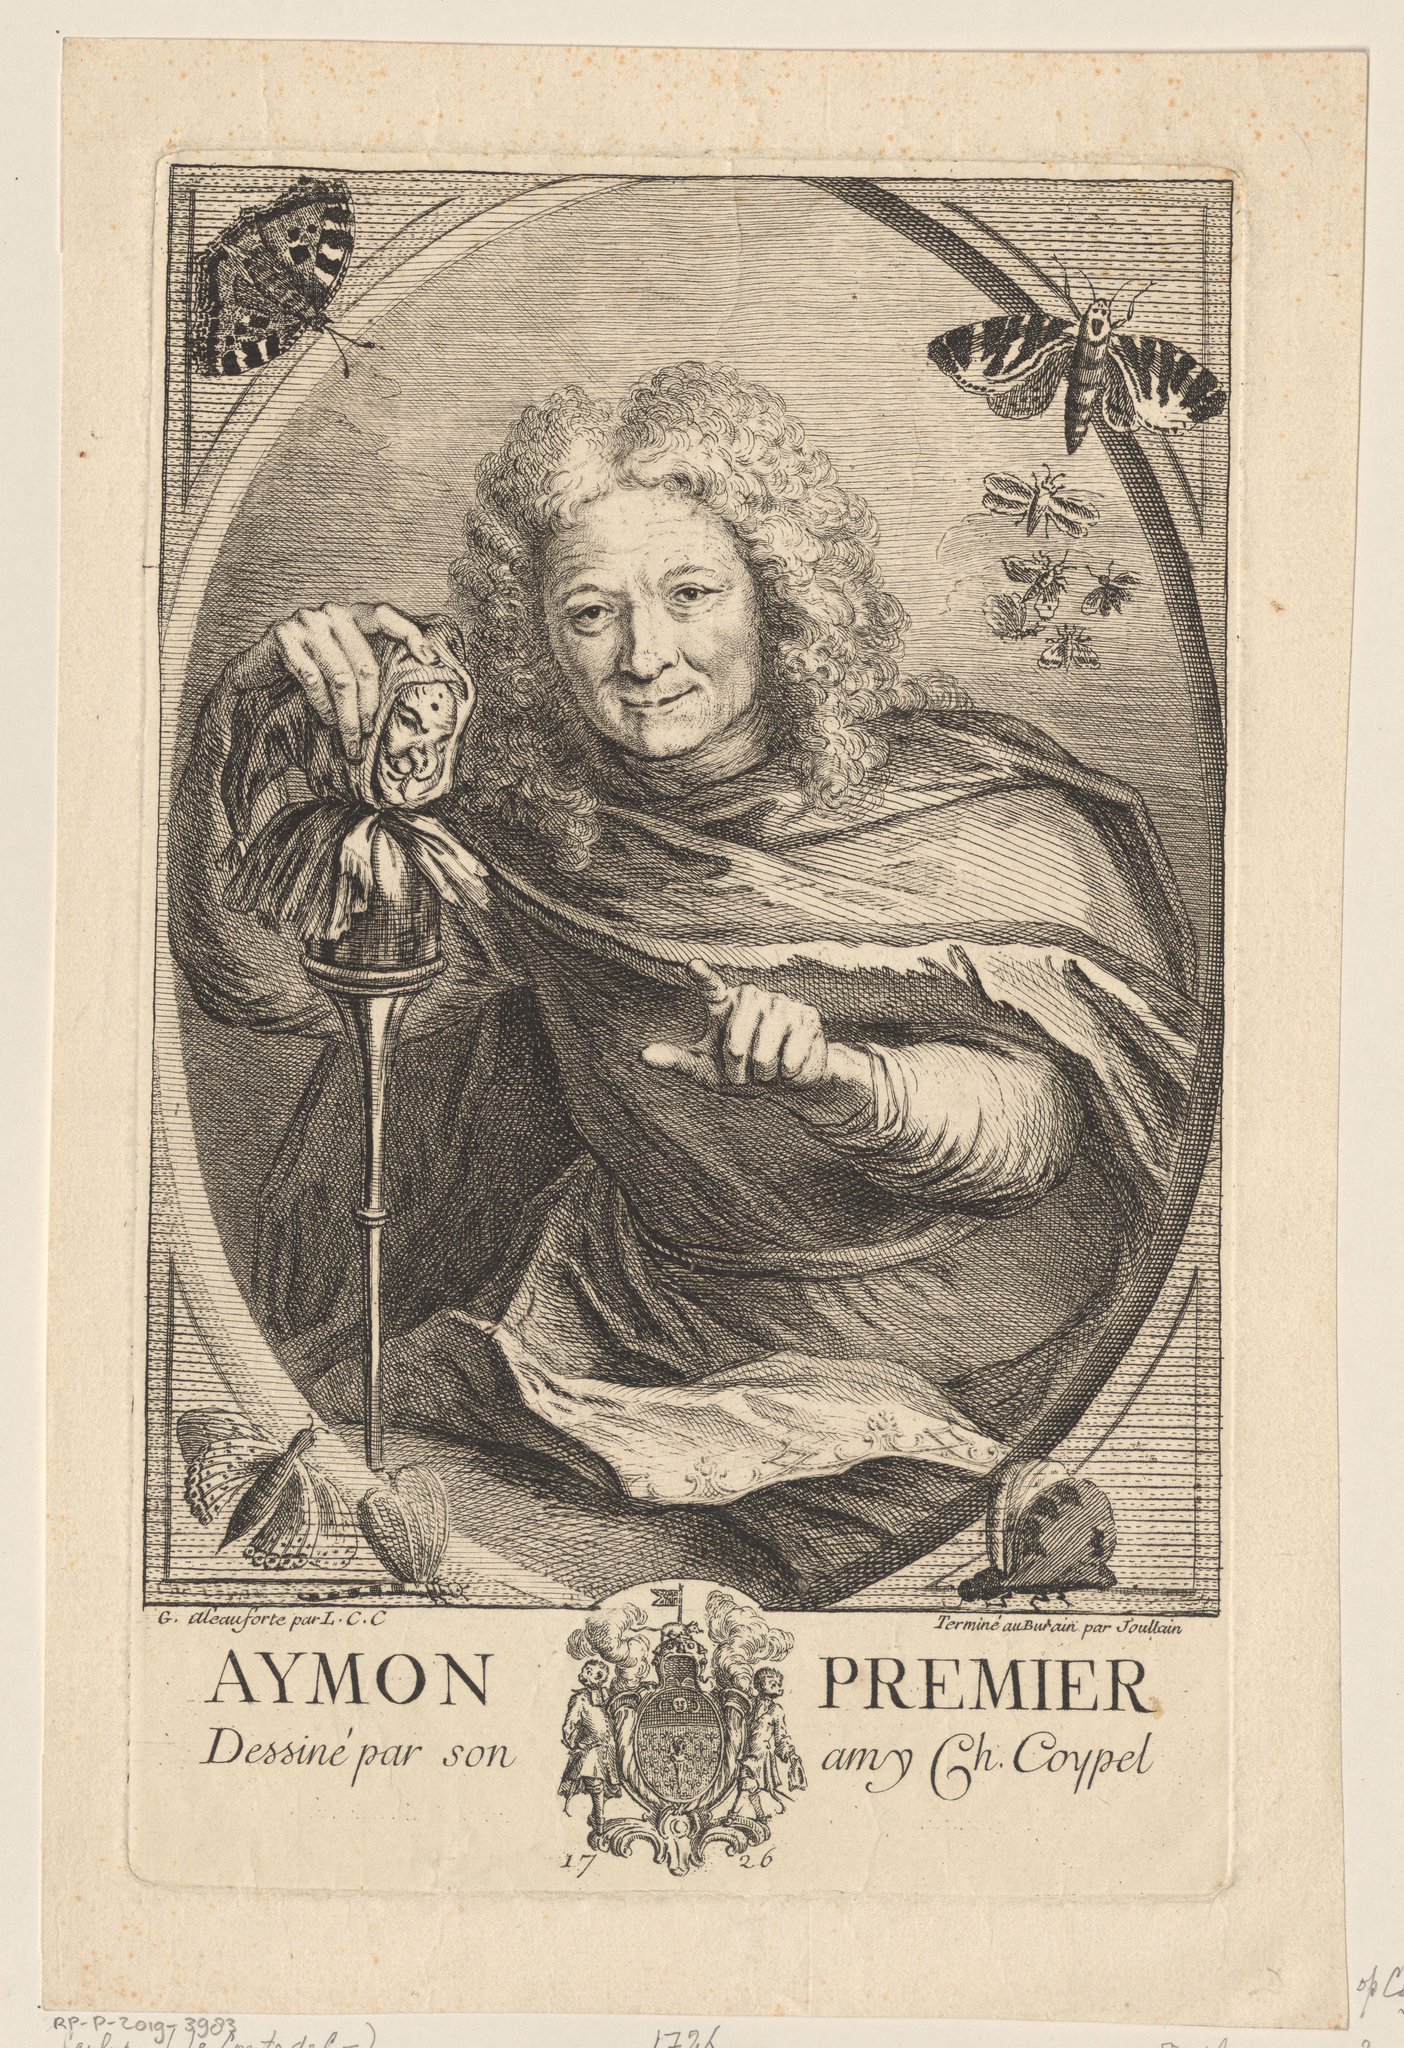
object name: print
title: Portret van Étienne Isidore Théophile Aymon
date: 1726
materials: paper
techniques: engraving, etching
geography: france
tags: historical persons, insects: butterfly, armorial bearing, heraldry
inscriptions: date